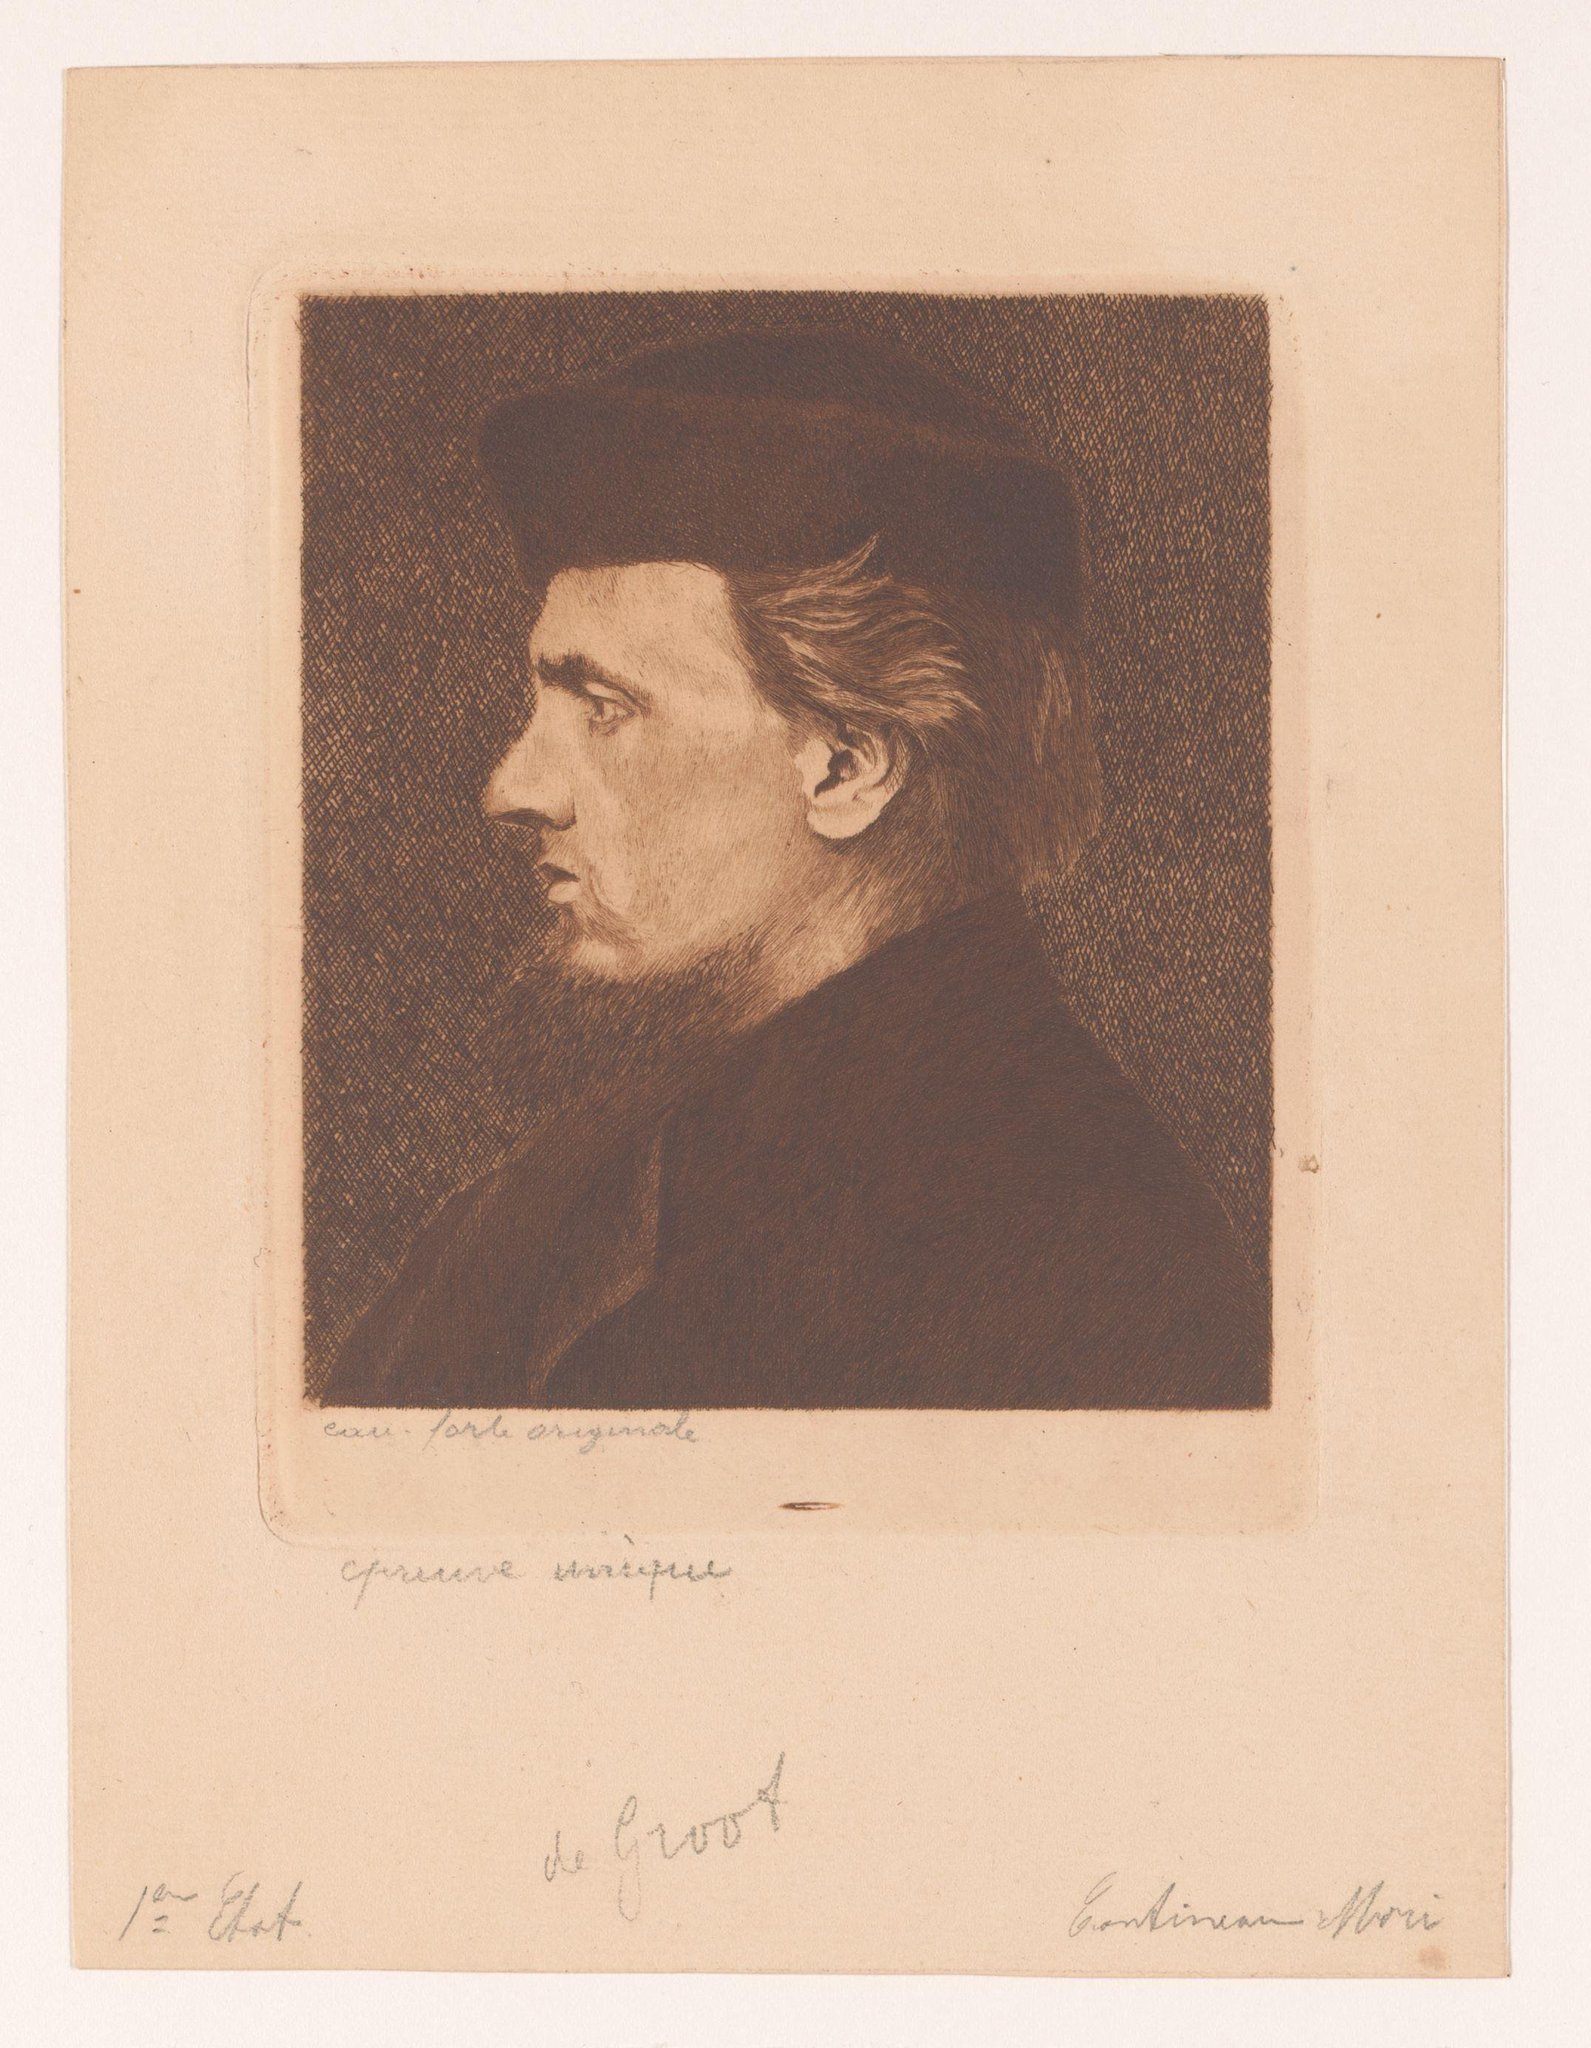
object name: print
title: En profil portret van Hugo de Groot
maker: mary hector rupert cantineau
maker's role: draughtsman, print maker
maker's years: 1875-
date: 1885-1909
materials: paper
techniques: drypoint, etching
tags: delft, hugo de groot, historical person (...) - historical person (...) portrayed alone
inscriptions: annotation: ‘epreuve unique’, collector's mark: Lugt 2228, annotation: ‘1er état’, annotation: ‘eau-forte originale’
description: Sterfdatum prentmaker onbekend. Derhalve is voor bepaling van de rechten van dit object de verwervingsdatum aangehouden.